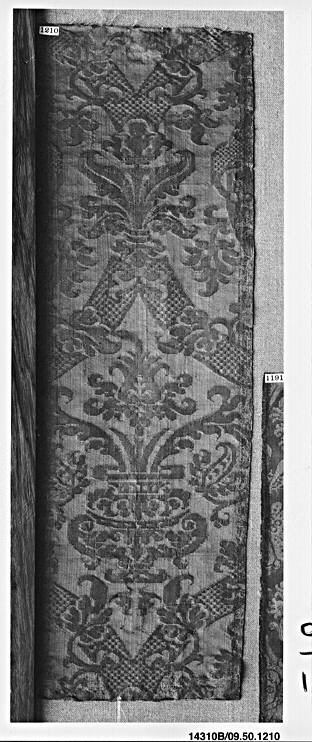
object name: piece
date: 1501-1600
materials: silk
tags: leaves